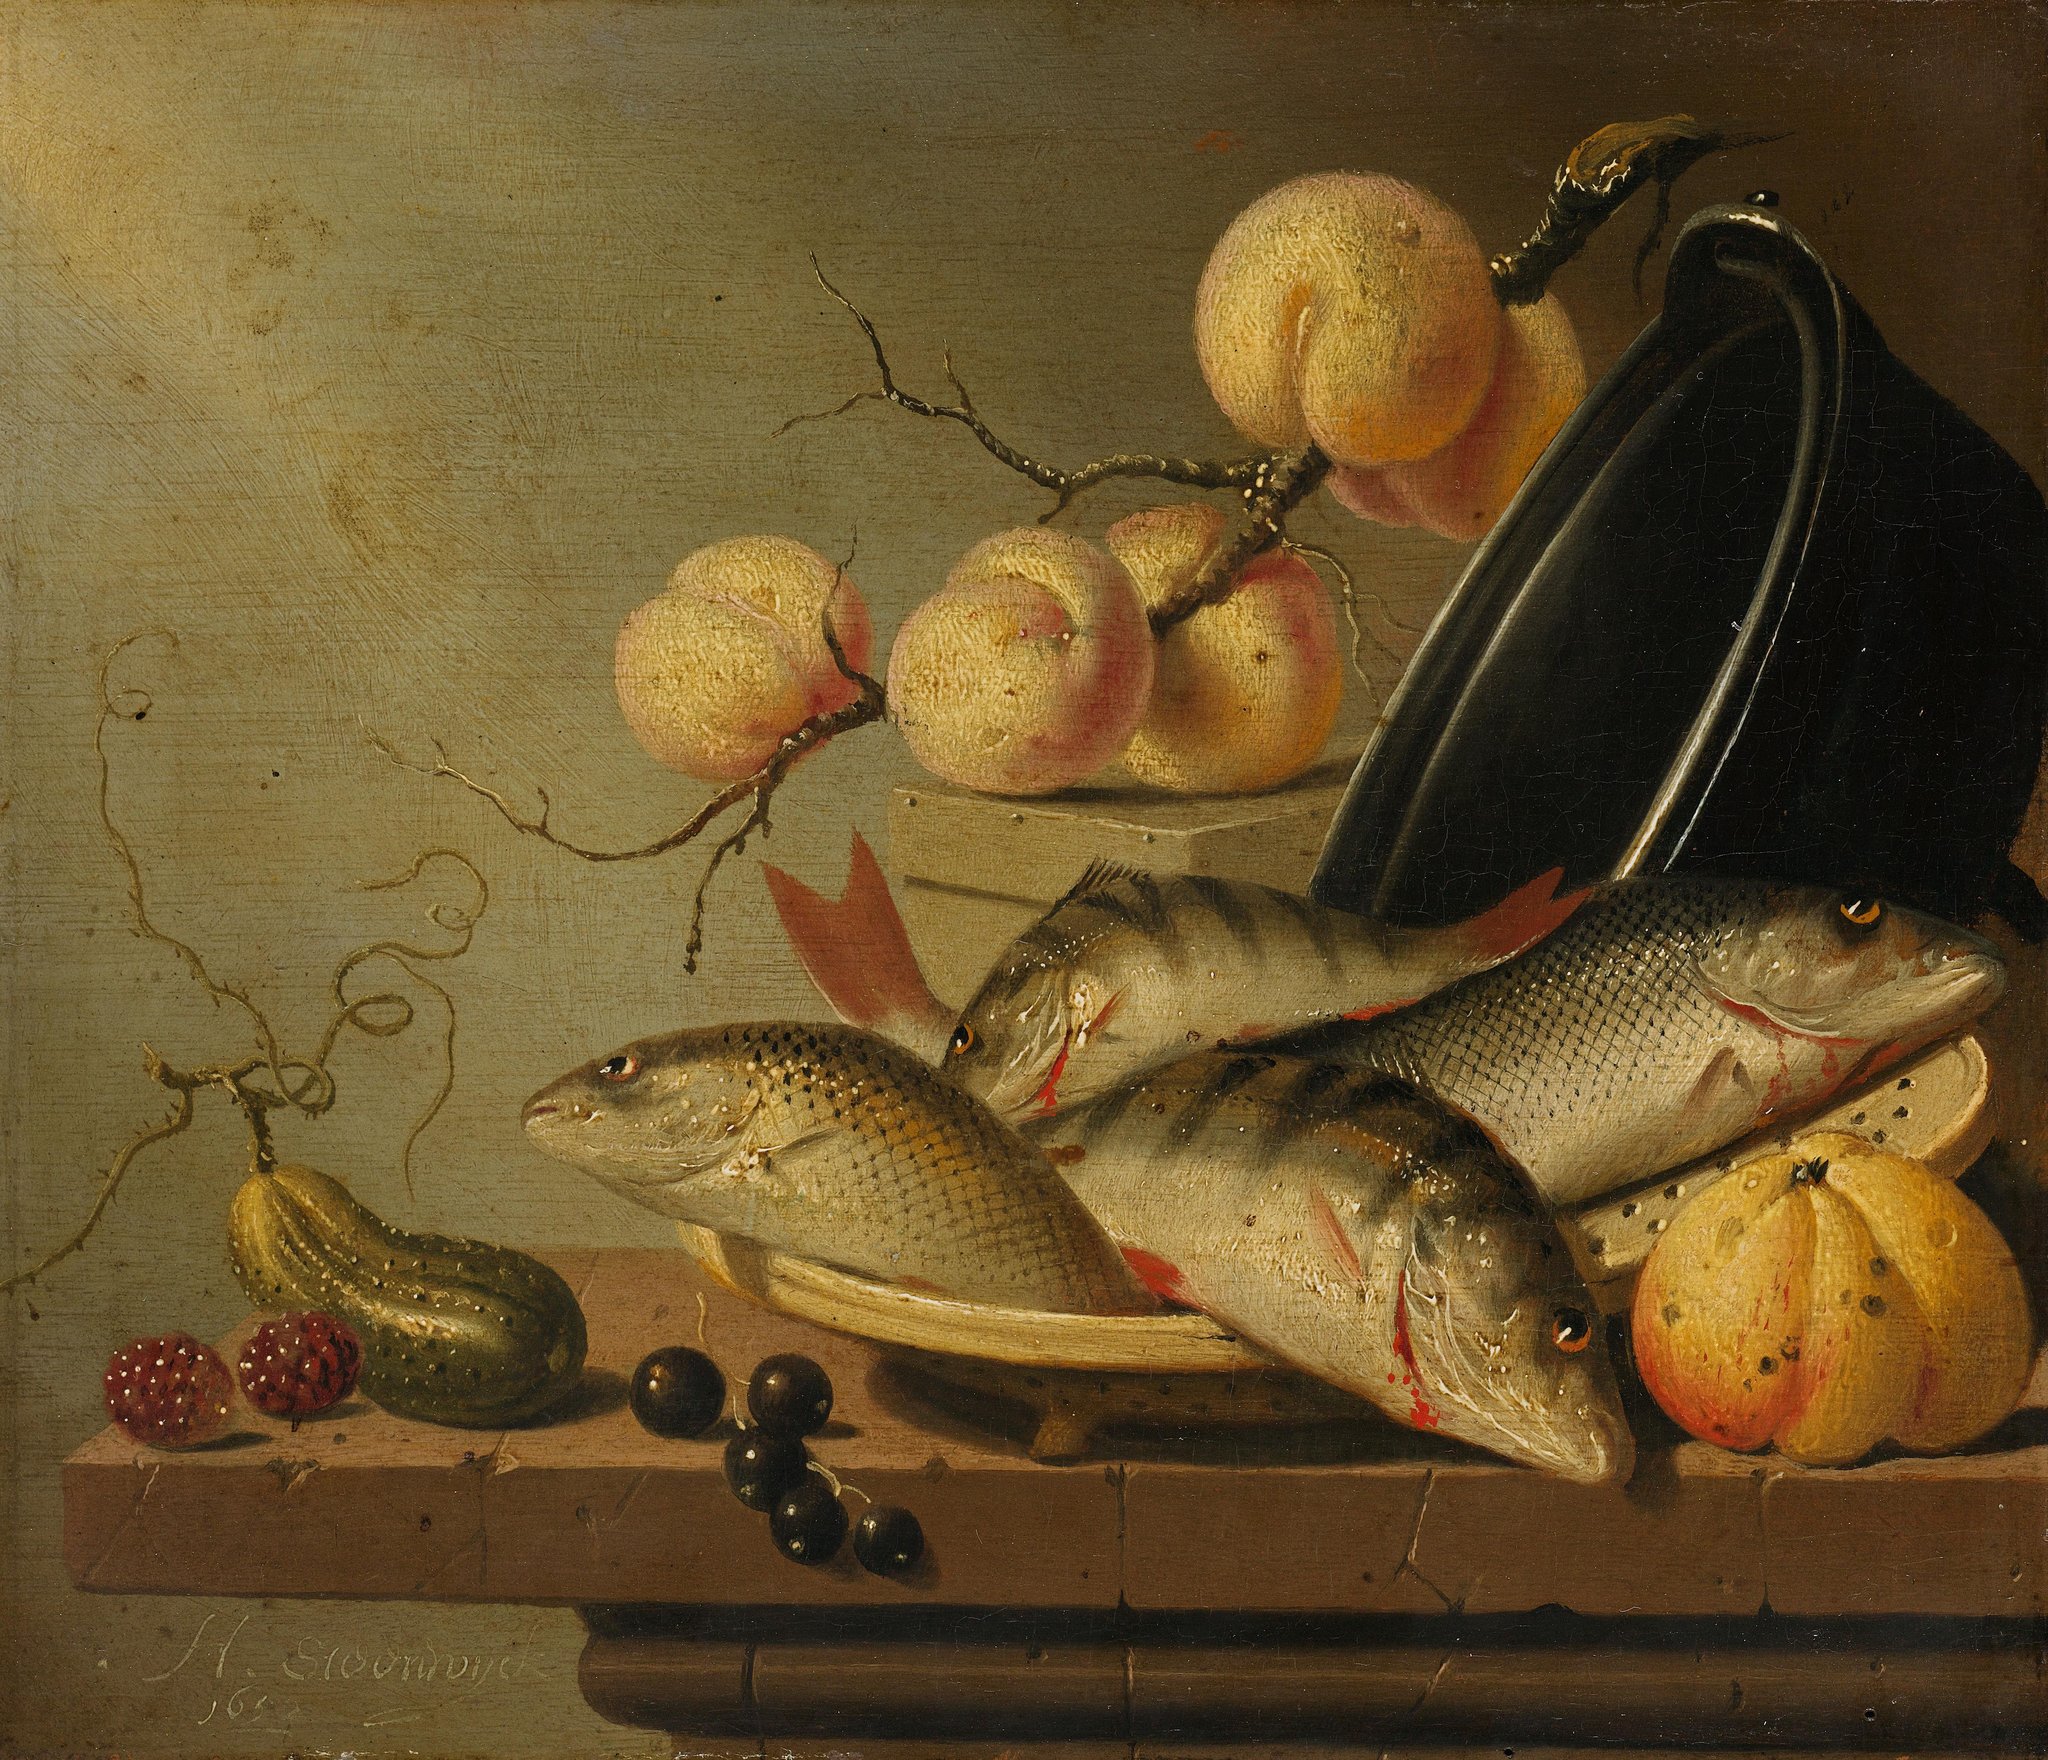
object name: painting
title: Still Life with Fish and Fruit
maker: harmen steenwijck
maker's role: painter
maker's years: 1602-1676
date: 1652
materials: oil, panel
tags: foodstuffs; still life of foodstuffs, still life of miscellaneous objects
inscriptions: signature and date: ‘H. Steenwyck 1652’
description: Stilleven met vier vissen op een vergiet, een tak perziken, een emmer, enkele bessen en een komkommer. Pendant van SK-A-1528.